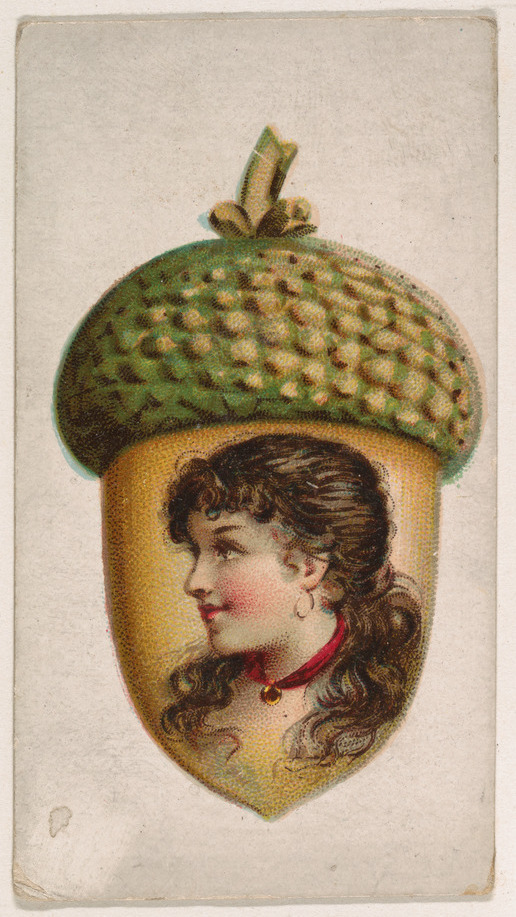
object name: print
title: Acorn, from the Novelties series (N228, Type 5) issued by Kinney Bros.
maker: kinney brothers tobacco company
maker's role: publisher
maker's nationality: american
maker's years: 1869-2011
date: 1889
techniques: color lithograph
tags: profiles,women,acorns